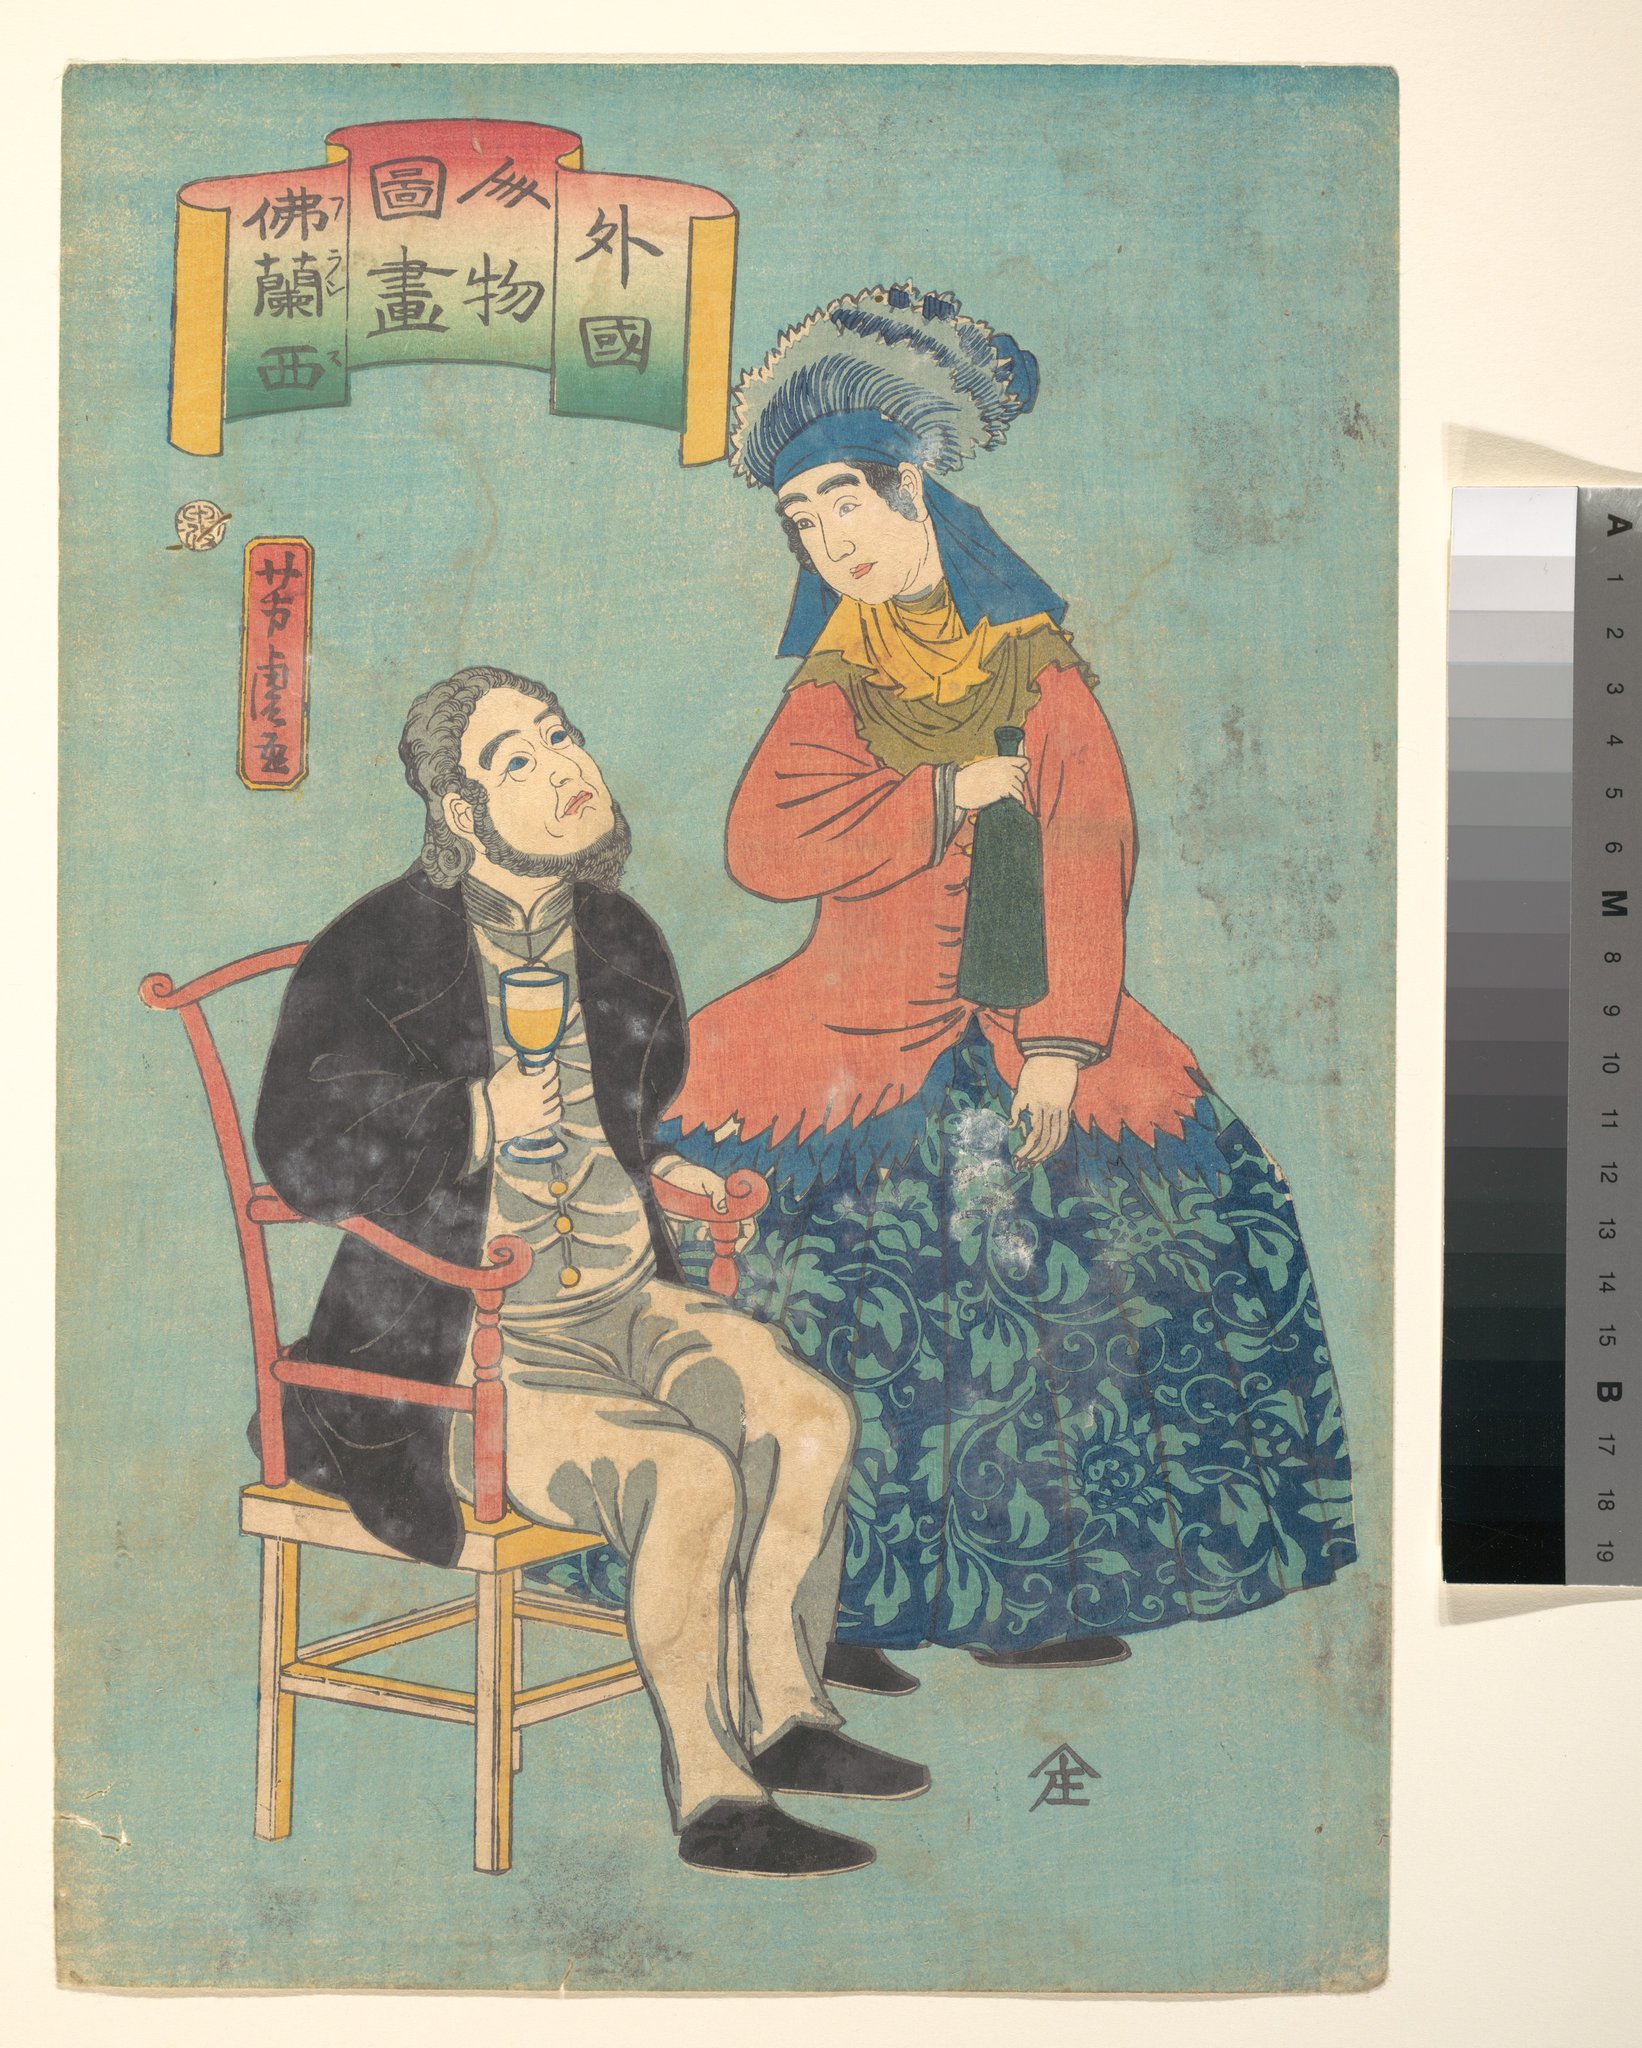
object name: print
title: France, from the series Pictures of People from Foreign Lands (Gaikoku jinbutsu zuga)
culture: japanese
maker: utagawa yoshitora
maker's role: artist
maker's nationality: japanese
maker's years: 1845-1880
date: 1850-1880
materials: ink, paper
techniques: woodblock print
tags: men,women,drinking